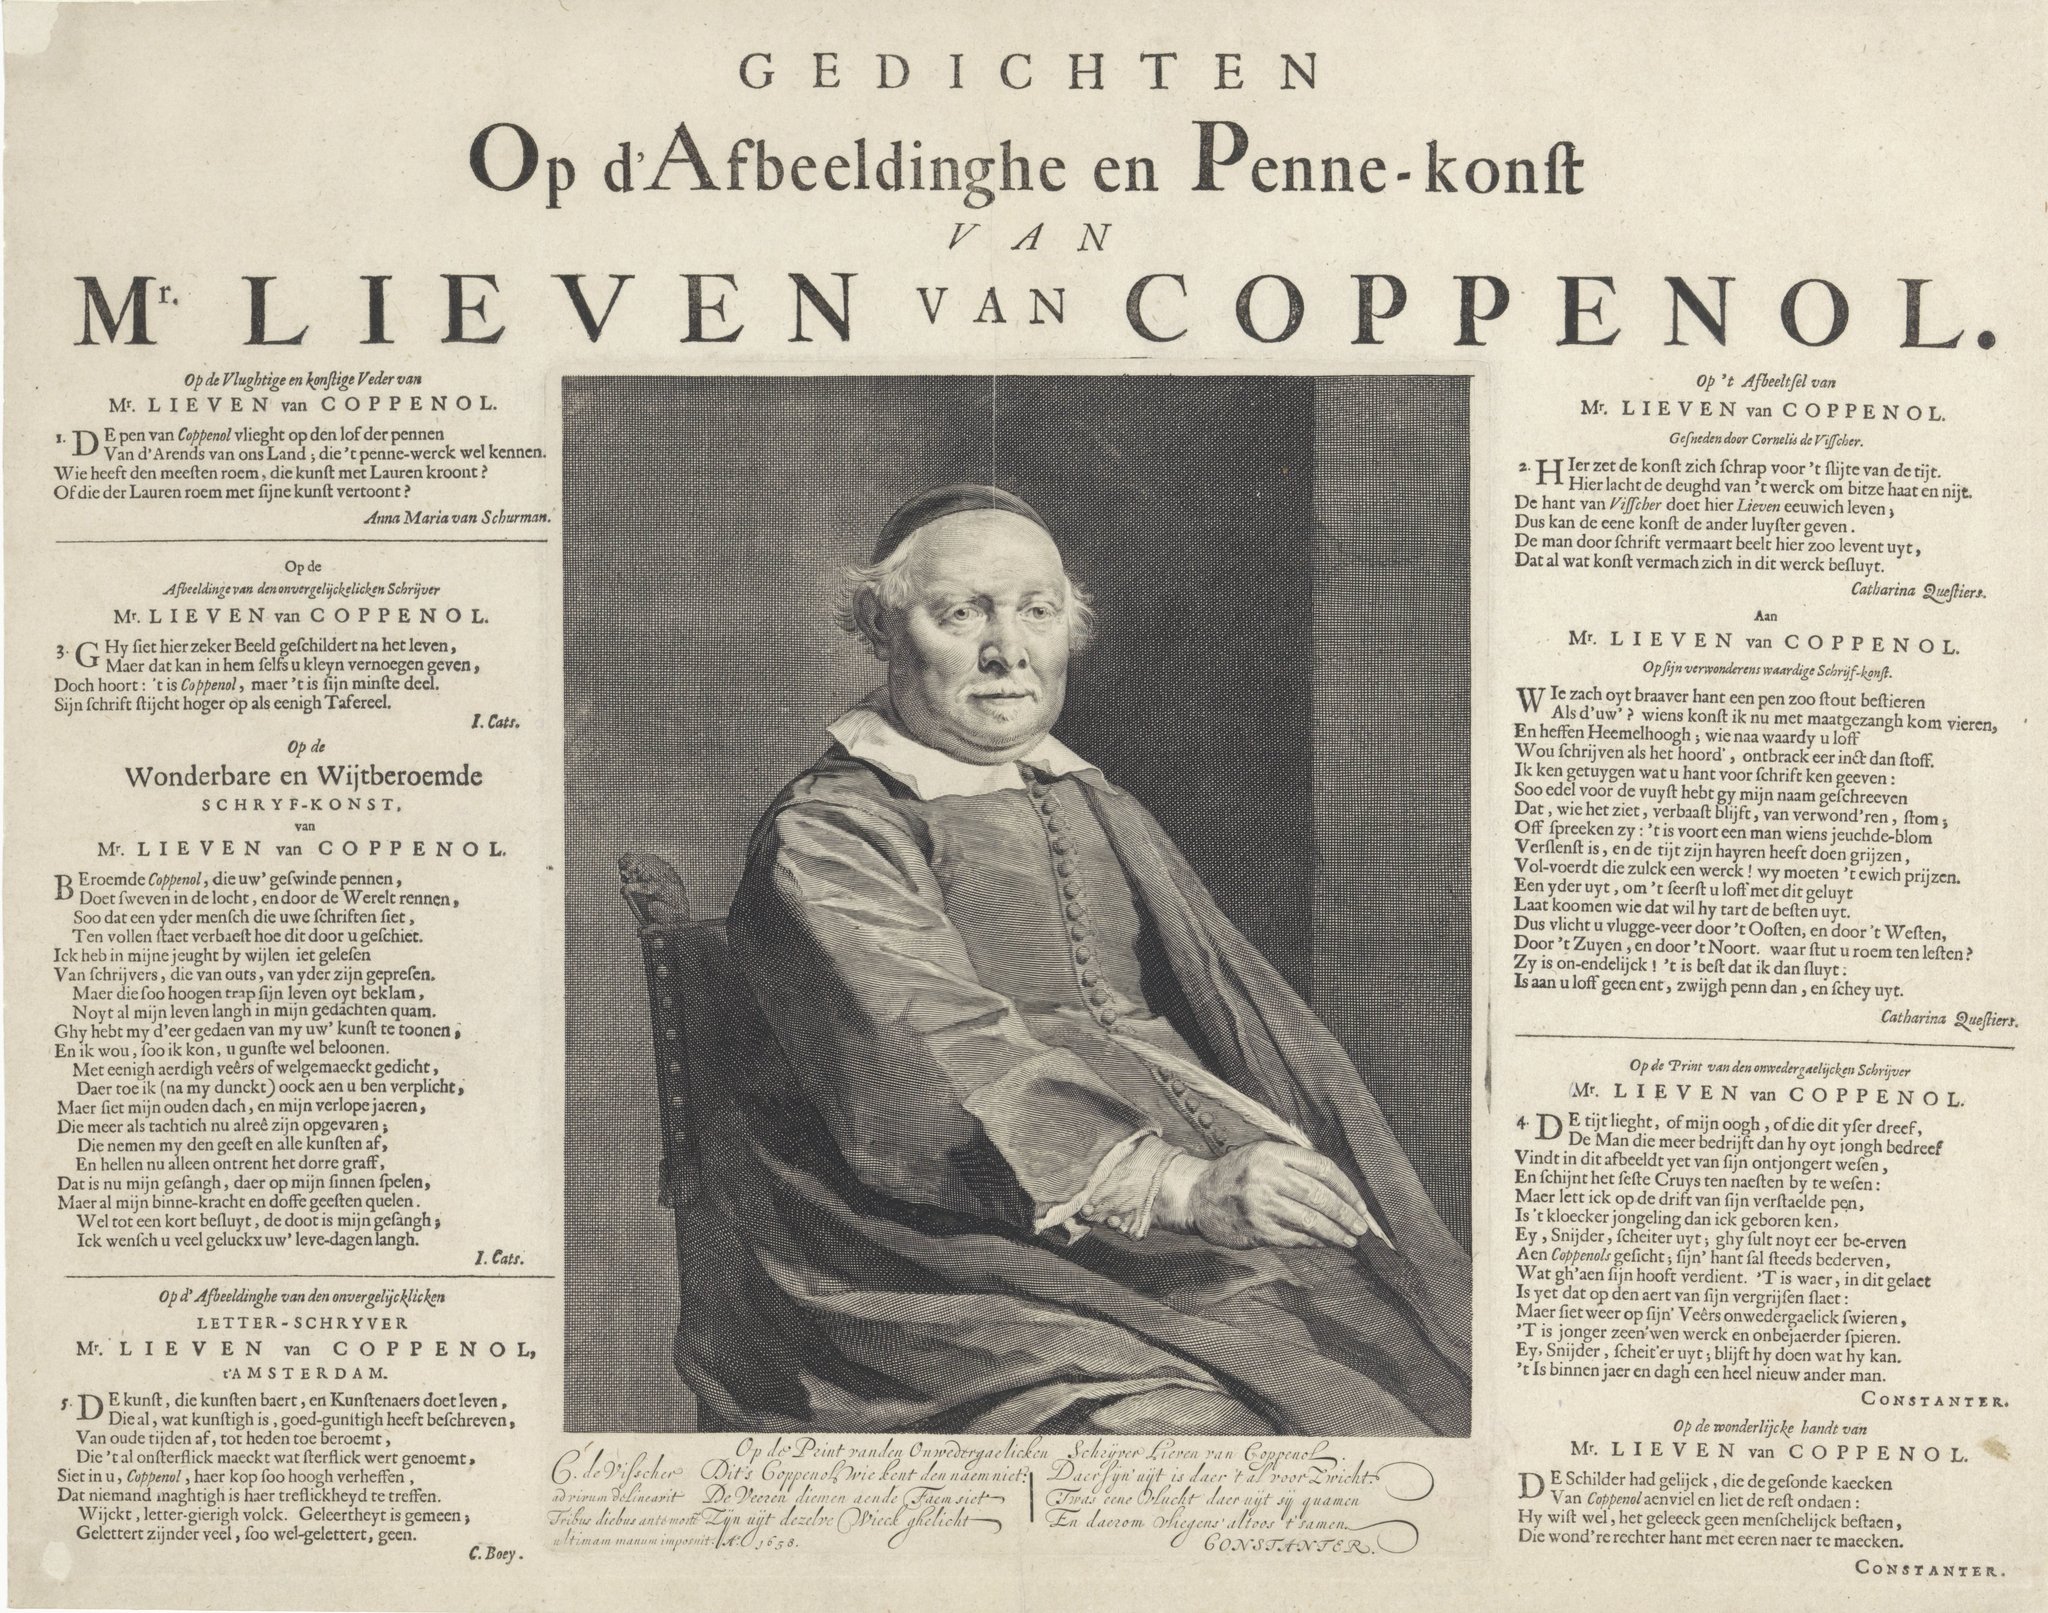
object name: print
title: Portret van Lieven Willemsz. van Coppenol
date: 1661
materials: paper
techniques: engraving, letterpress printing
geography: haarlem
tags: amsterdam, draughtsman, lieven willemsz. coppenol, quill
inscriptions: collector's mark: Lugt 240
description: De Amsterdamse schrijfmeester Lieven Willemsz. van Coppenol. De schoonschrijver zit in een vertrek op een stoel met een schrijfveer in zijn hand. Zijn portret is omgeven door lofgedichten van diverse schrijvers.